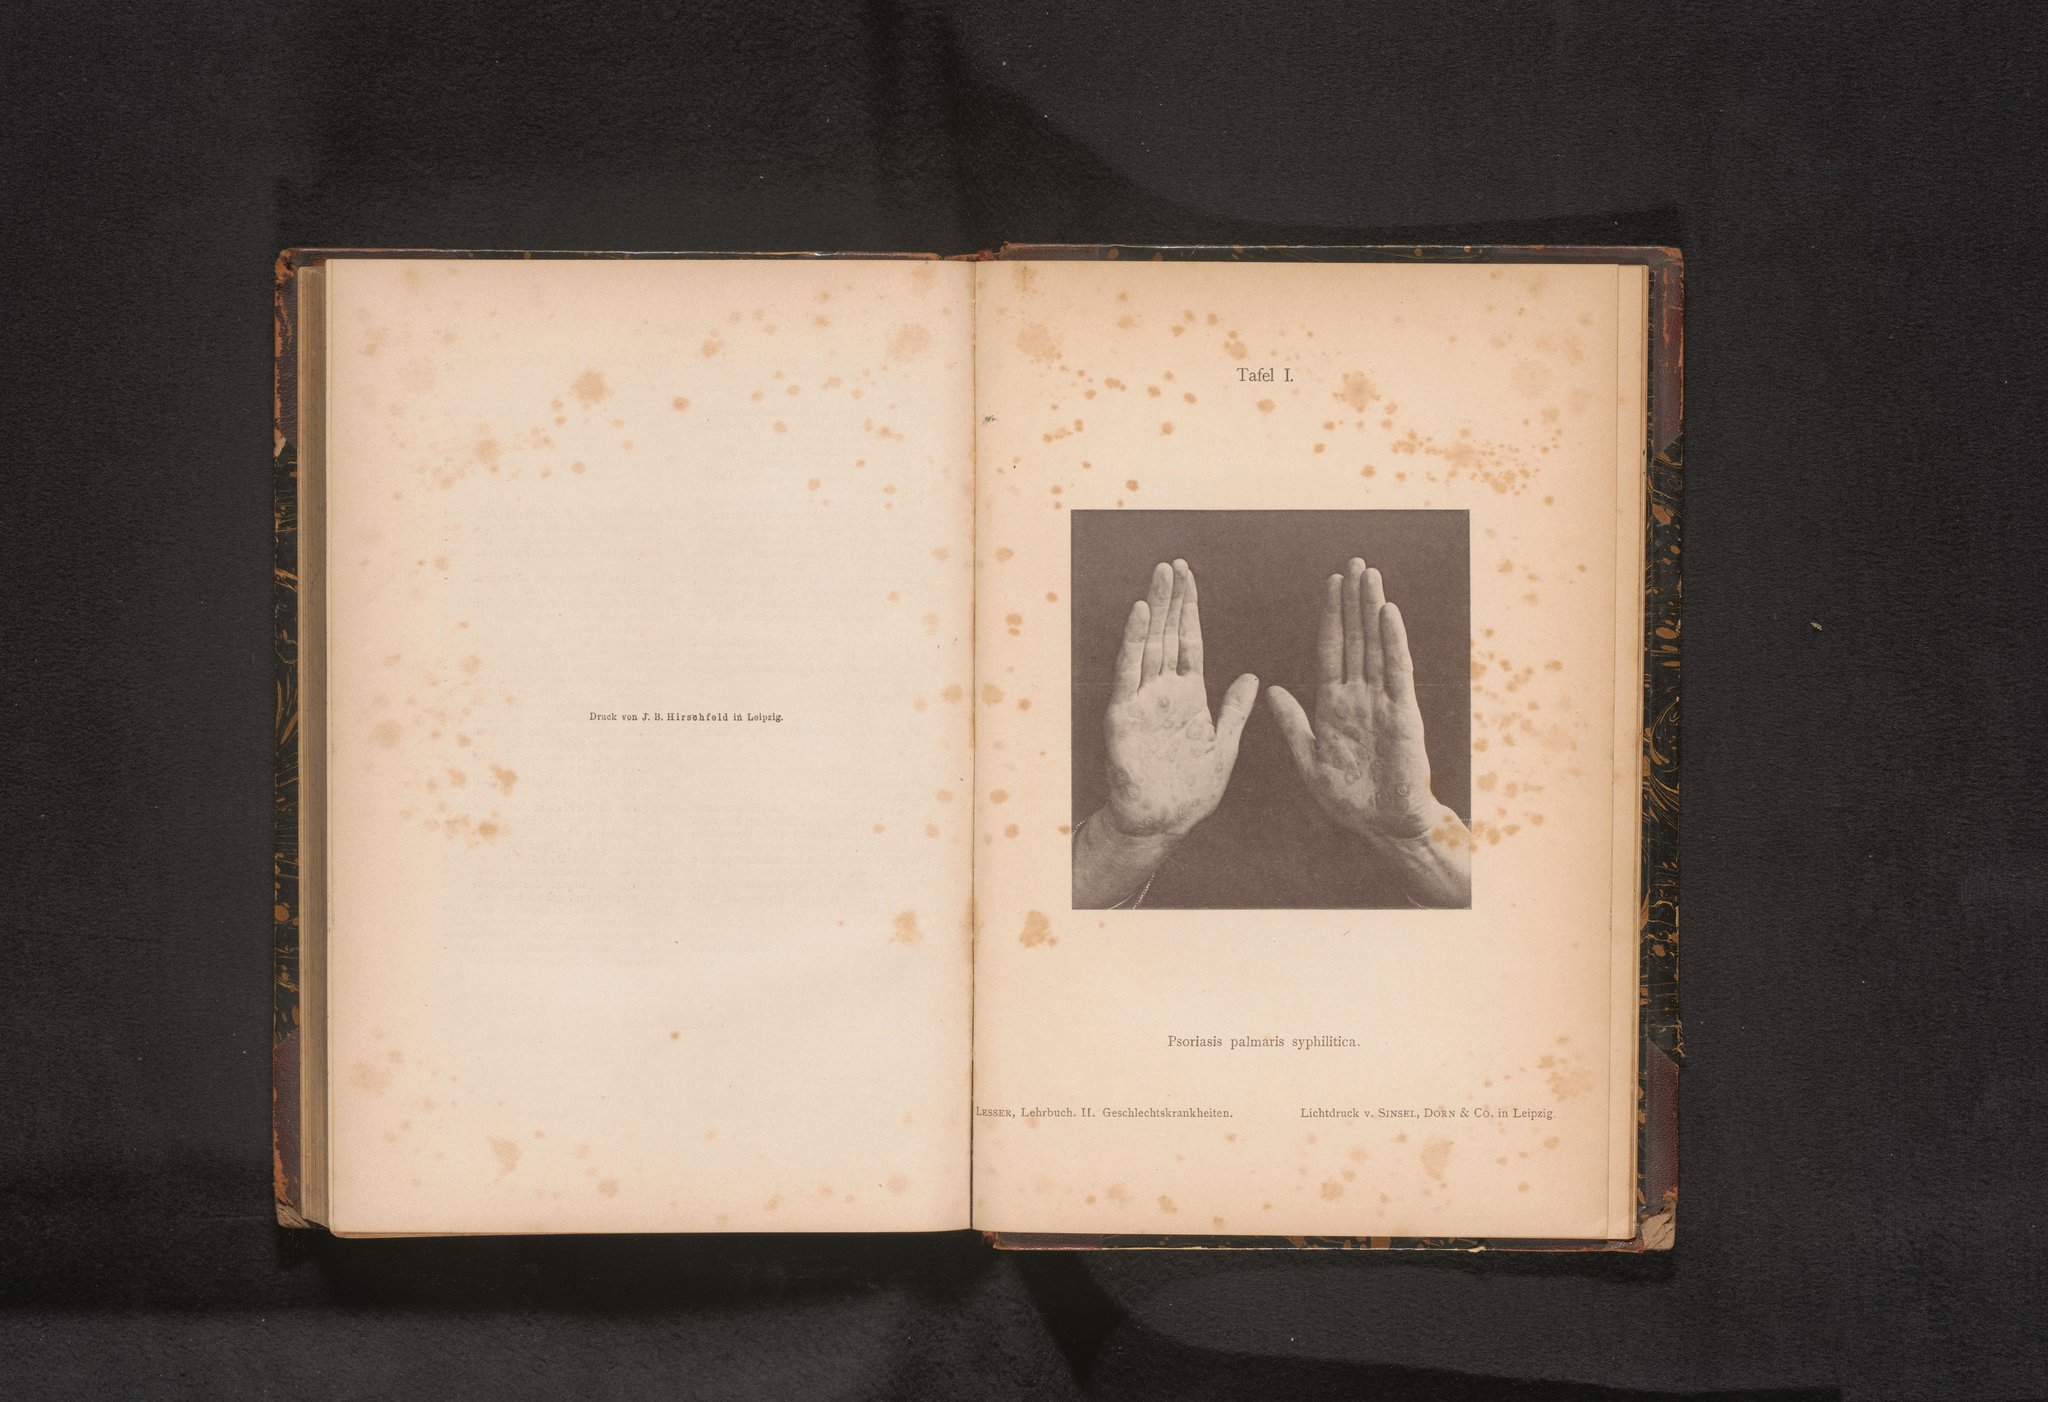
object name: page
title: Handen met huiduitslag veroorzaakt door syfilis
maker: Anonymous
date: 1880-1890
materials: paper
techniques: photograph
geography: leipzig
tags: skin and venereal diseases: syphilis - aa - epidemic diseases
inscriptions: number: ‘Tafel I.’